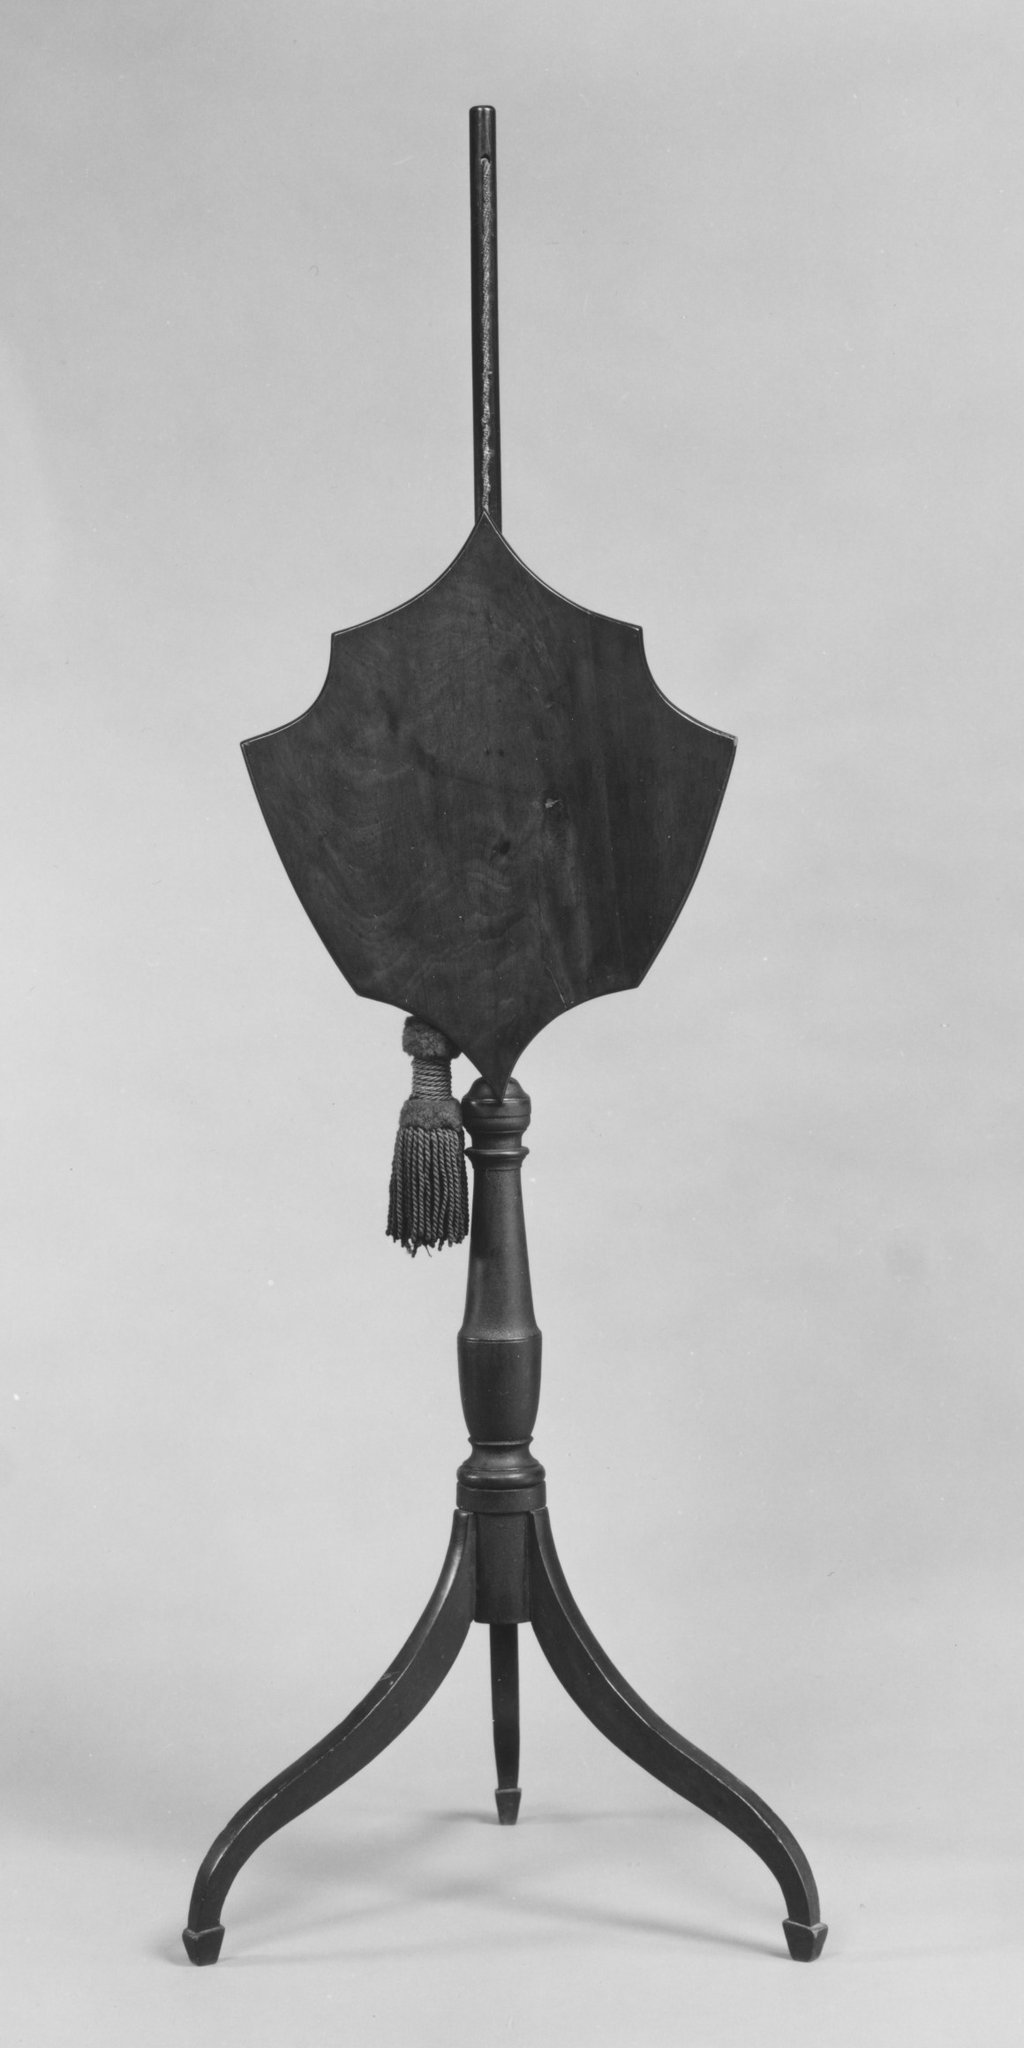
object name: firescreen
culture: american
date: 1790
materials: wood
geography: united states